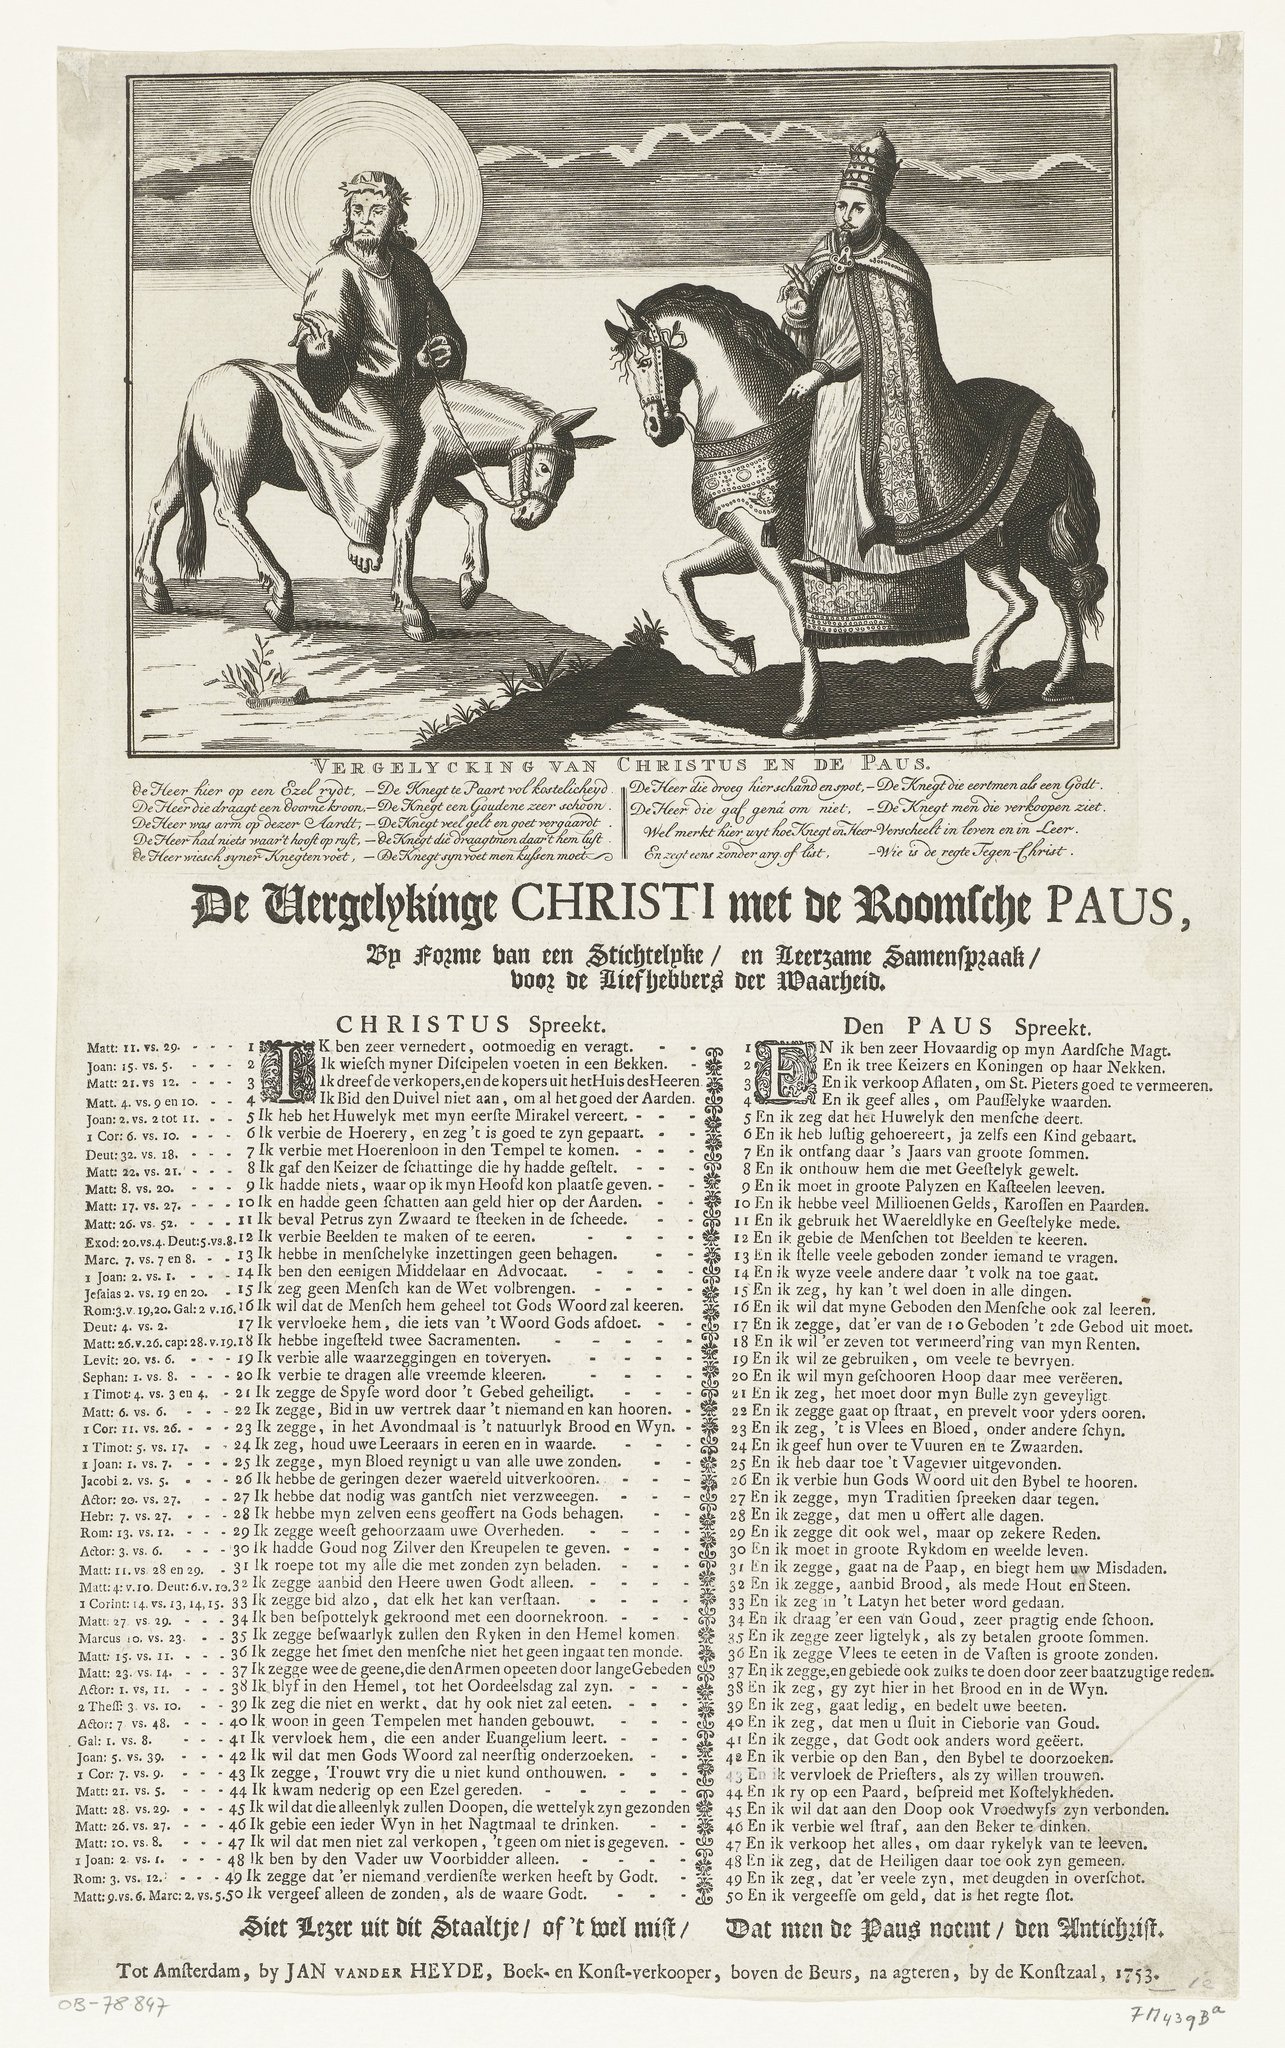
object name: print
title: Christus op de ezel, de paus te paard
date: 1753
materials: paper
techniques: etching, letterpress printing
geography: netherlands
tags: reformation (roman catholic church vs. protestantism), the pope on horseback, and christ on an ass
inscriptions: date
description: Christus op de ezel, de paus te paard. Vergelijking tussen de nederigheid van Christus en de hoogmoed van de paus. Met onderschrift in de plaat van 2 keer 2 kolommen van 5 en 4 regels en aparte tekst op blad met 50 genummerde verschillen tussen Christus en de paus in het Nederlands. Spotprent op de paus en de Roomse kerk, waarin gebruikt wordt gemaakt van een oorspronkelijk zestiende-eeuws beeldmotief.